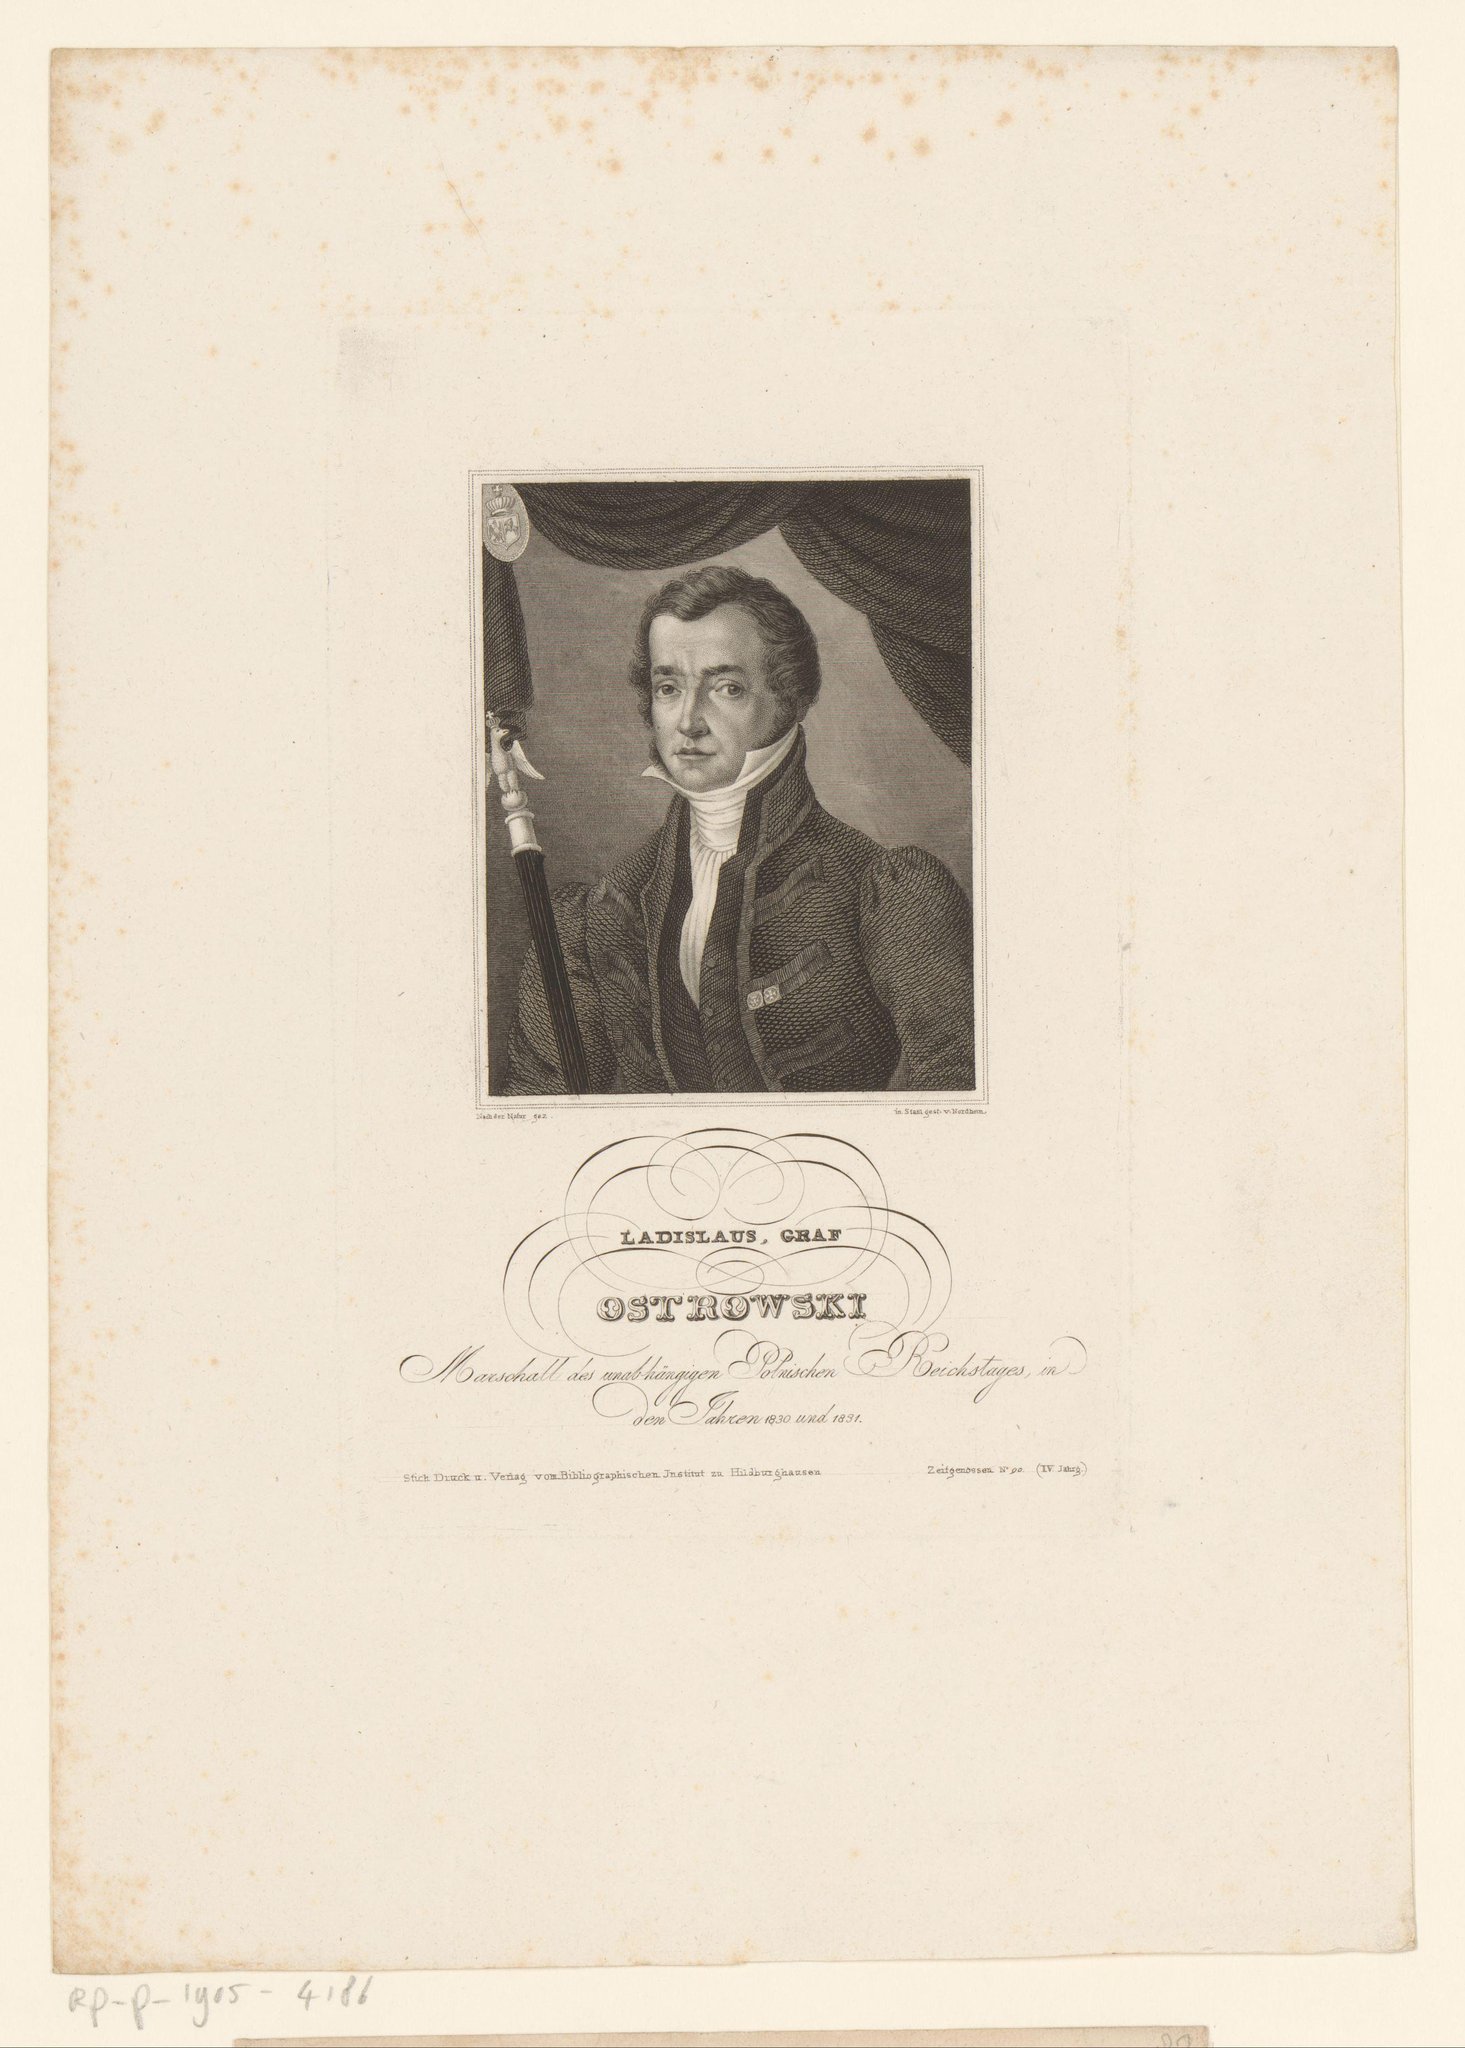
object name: print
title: Tijdgenoten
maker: johann georg nordheim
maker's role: print maker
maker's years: 1804-1853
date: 1829-1840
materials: paper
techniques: etching, engraving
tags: politician, historical persons, insignia and symbols of sovereignty (crown, diadem, sceptre, orb, seal, standard, cloak, pectoral)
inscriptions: collector's mark: Lugt 2228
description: Afkomstig uit de portretserie 'Zeitgenossen', uitgegeven tussen 1829 en circa 1840.